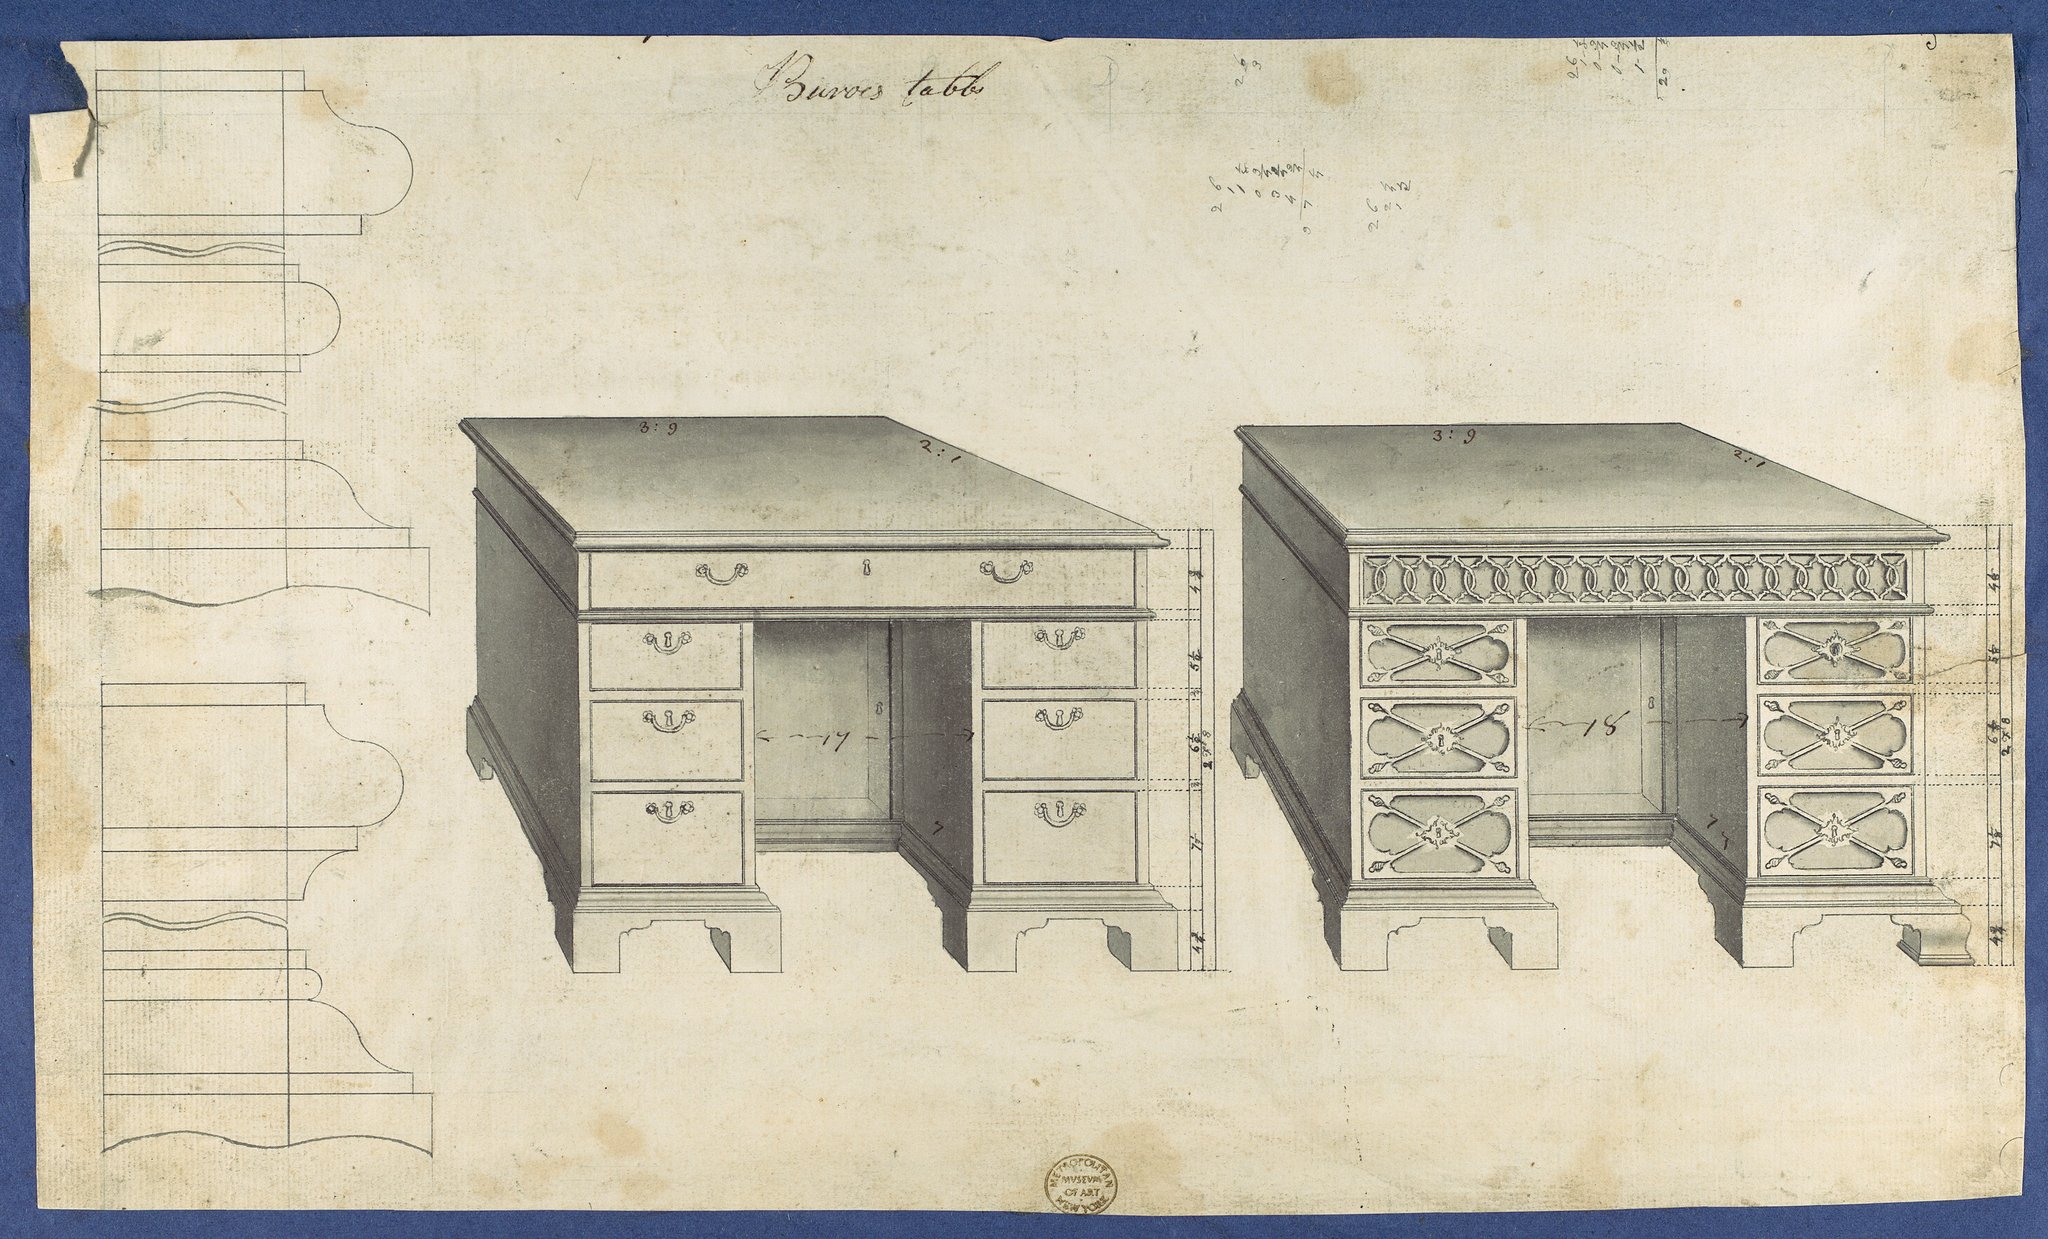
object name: drawing ornament architecture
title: Bureau Tables, from Chippendale Drawings, Vol. II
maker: thomas chippendale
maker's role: artist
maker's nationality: british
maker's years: 1718-1779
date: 1753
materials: ink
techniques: wash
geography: london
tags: tables